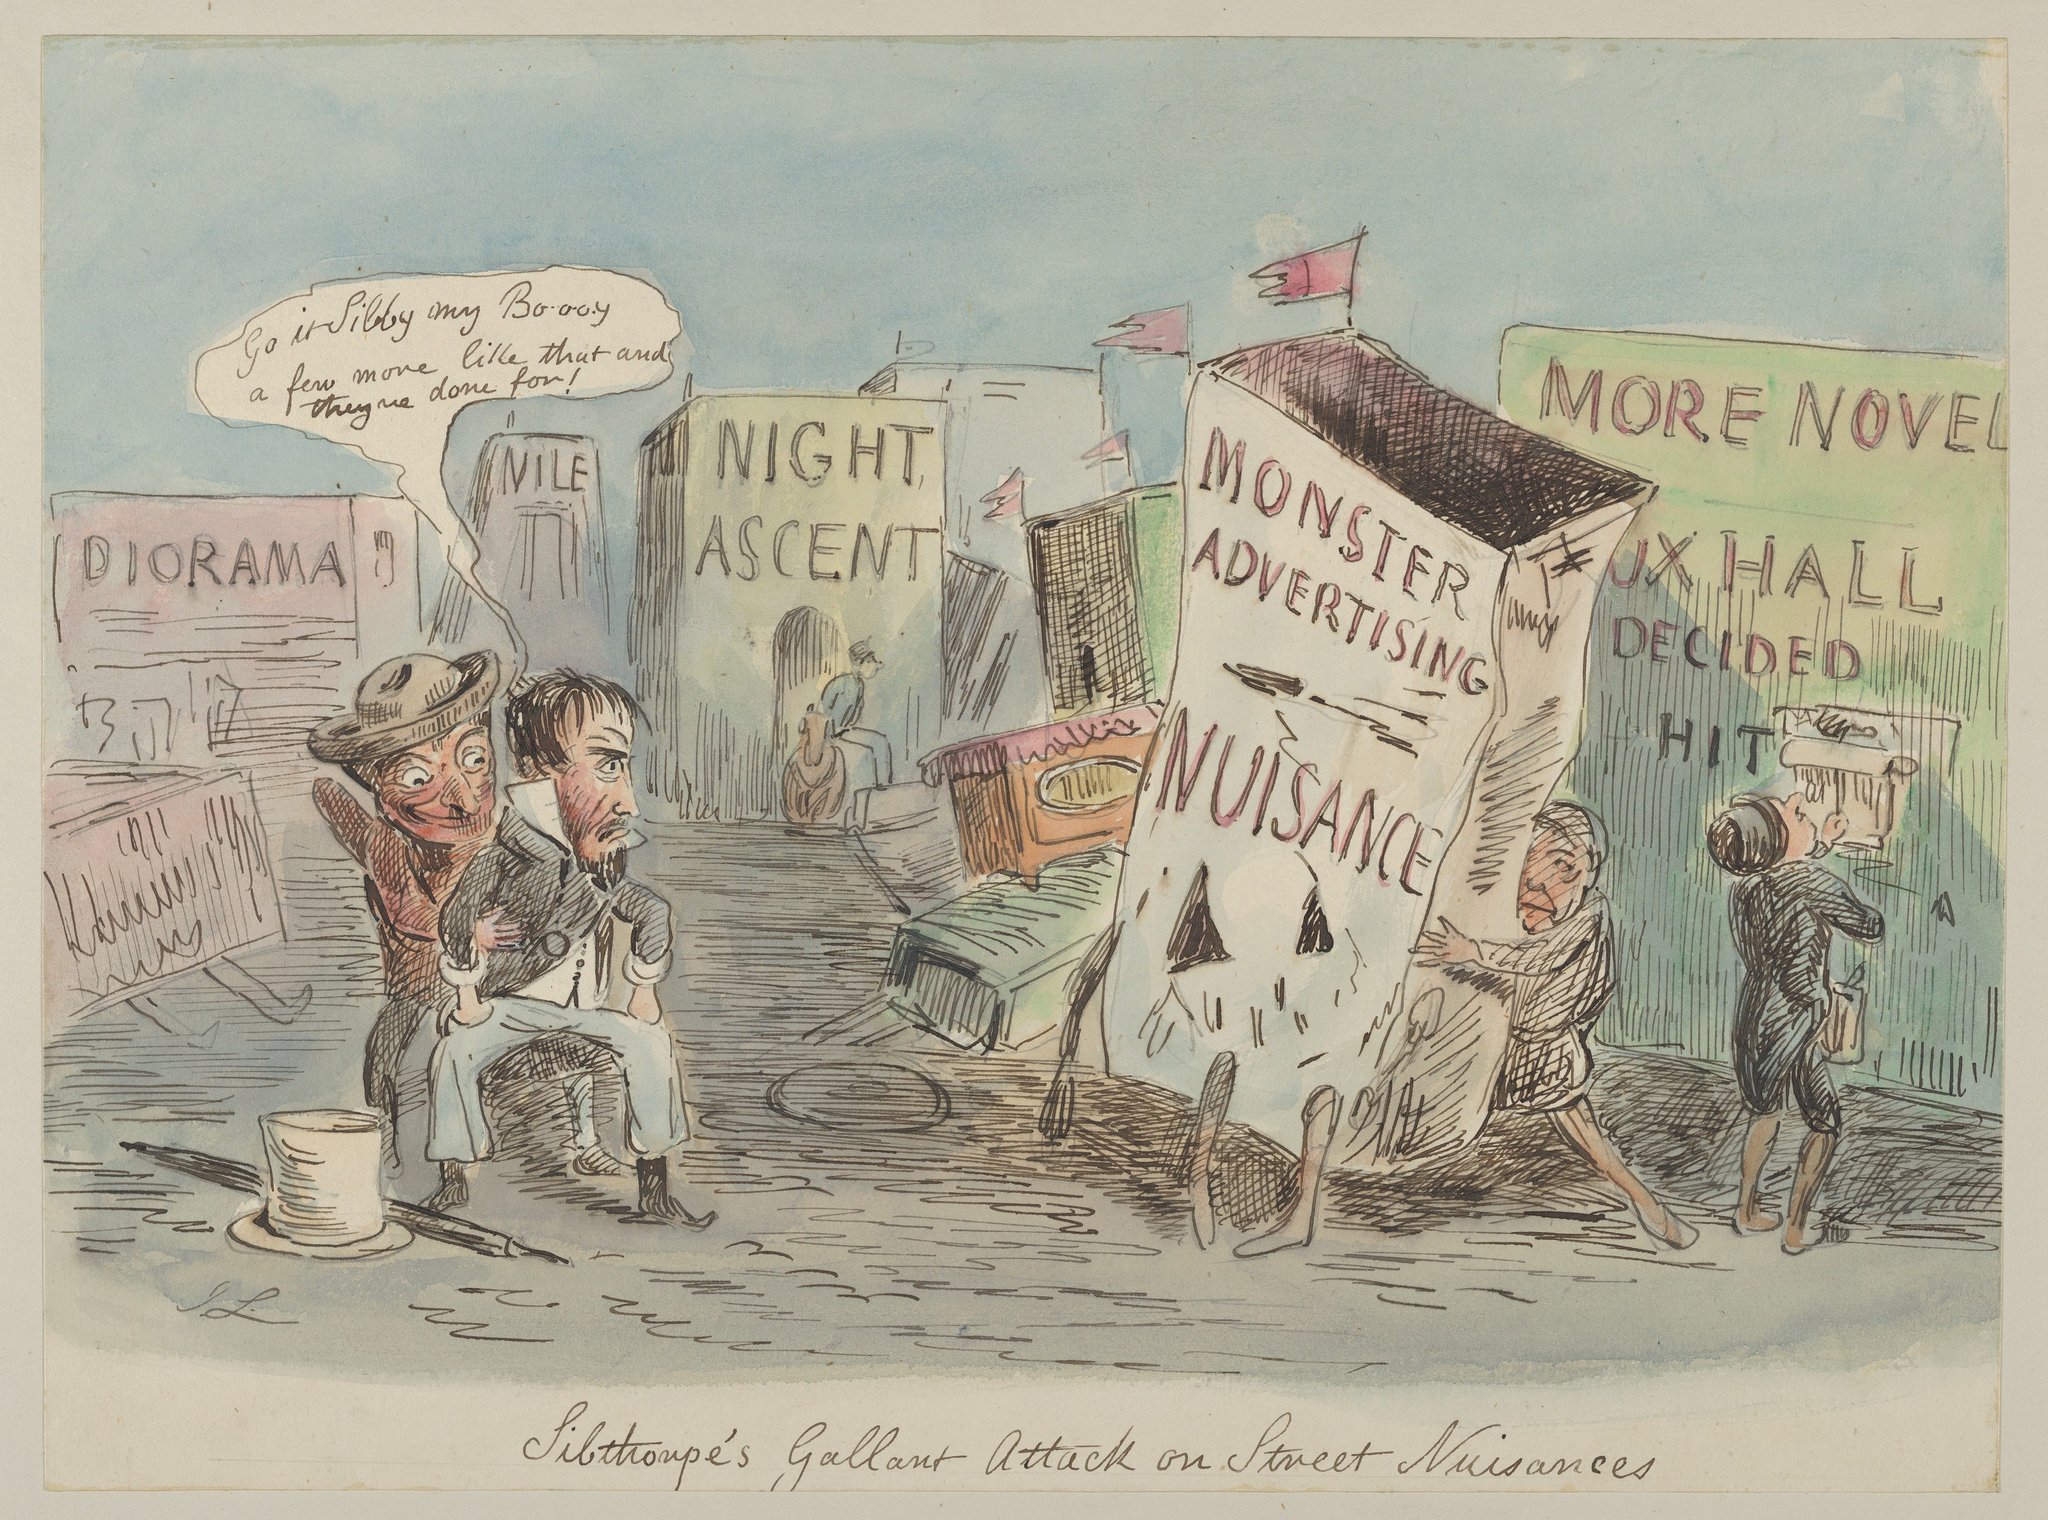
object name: drawing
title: Lilthorpe's Gallant Attack on Street, Nuisances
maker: john leech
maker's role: artist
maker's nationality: british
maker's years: 1817-1864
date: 1830-1864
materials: ink, watercolor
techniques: pen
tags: satire,streets,men